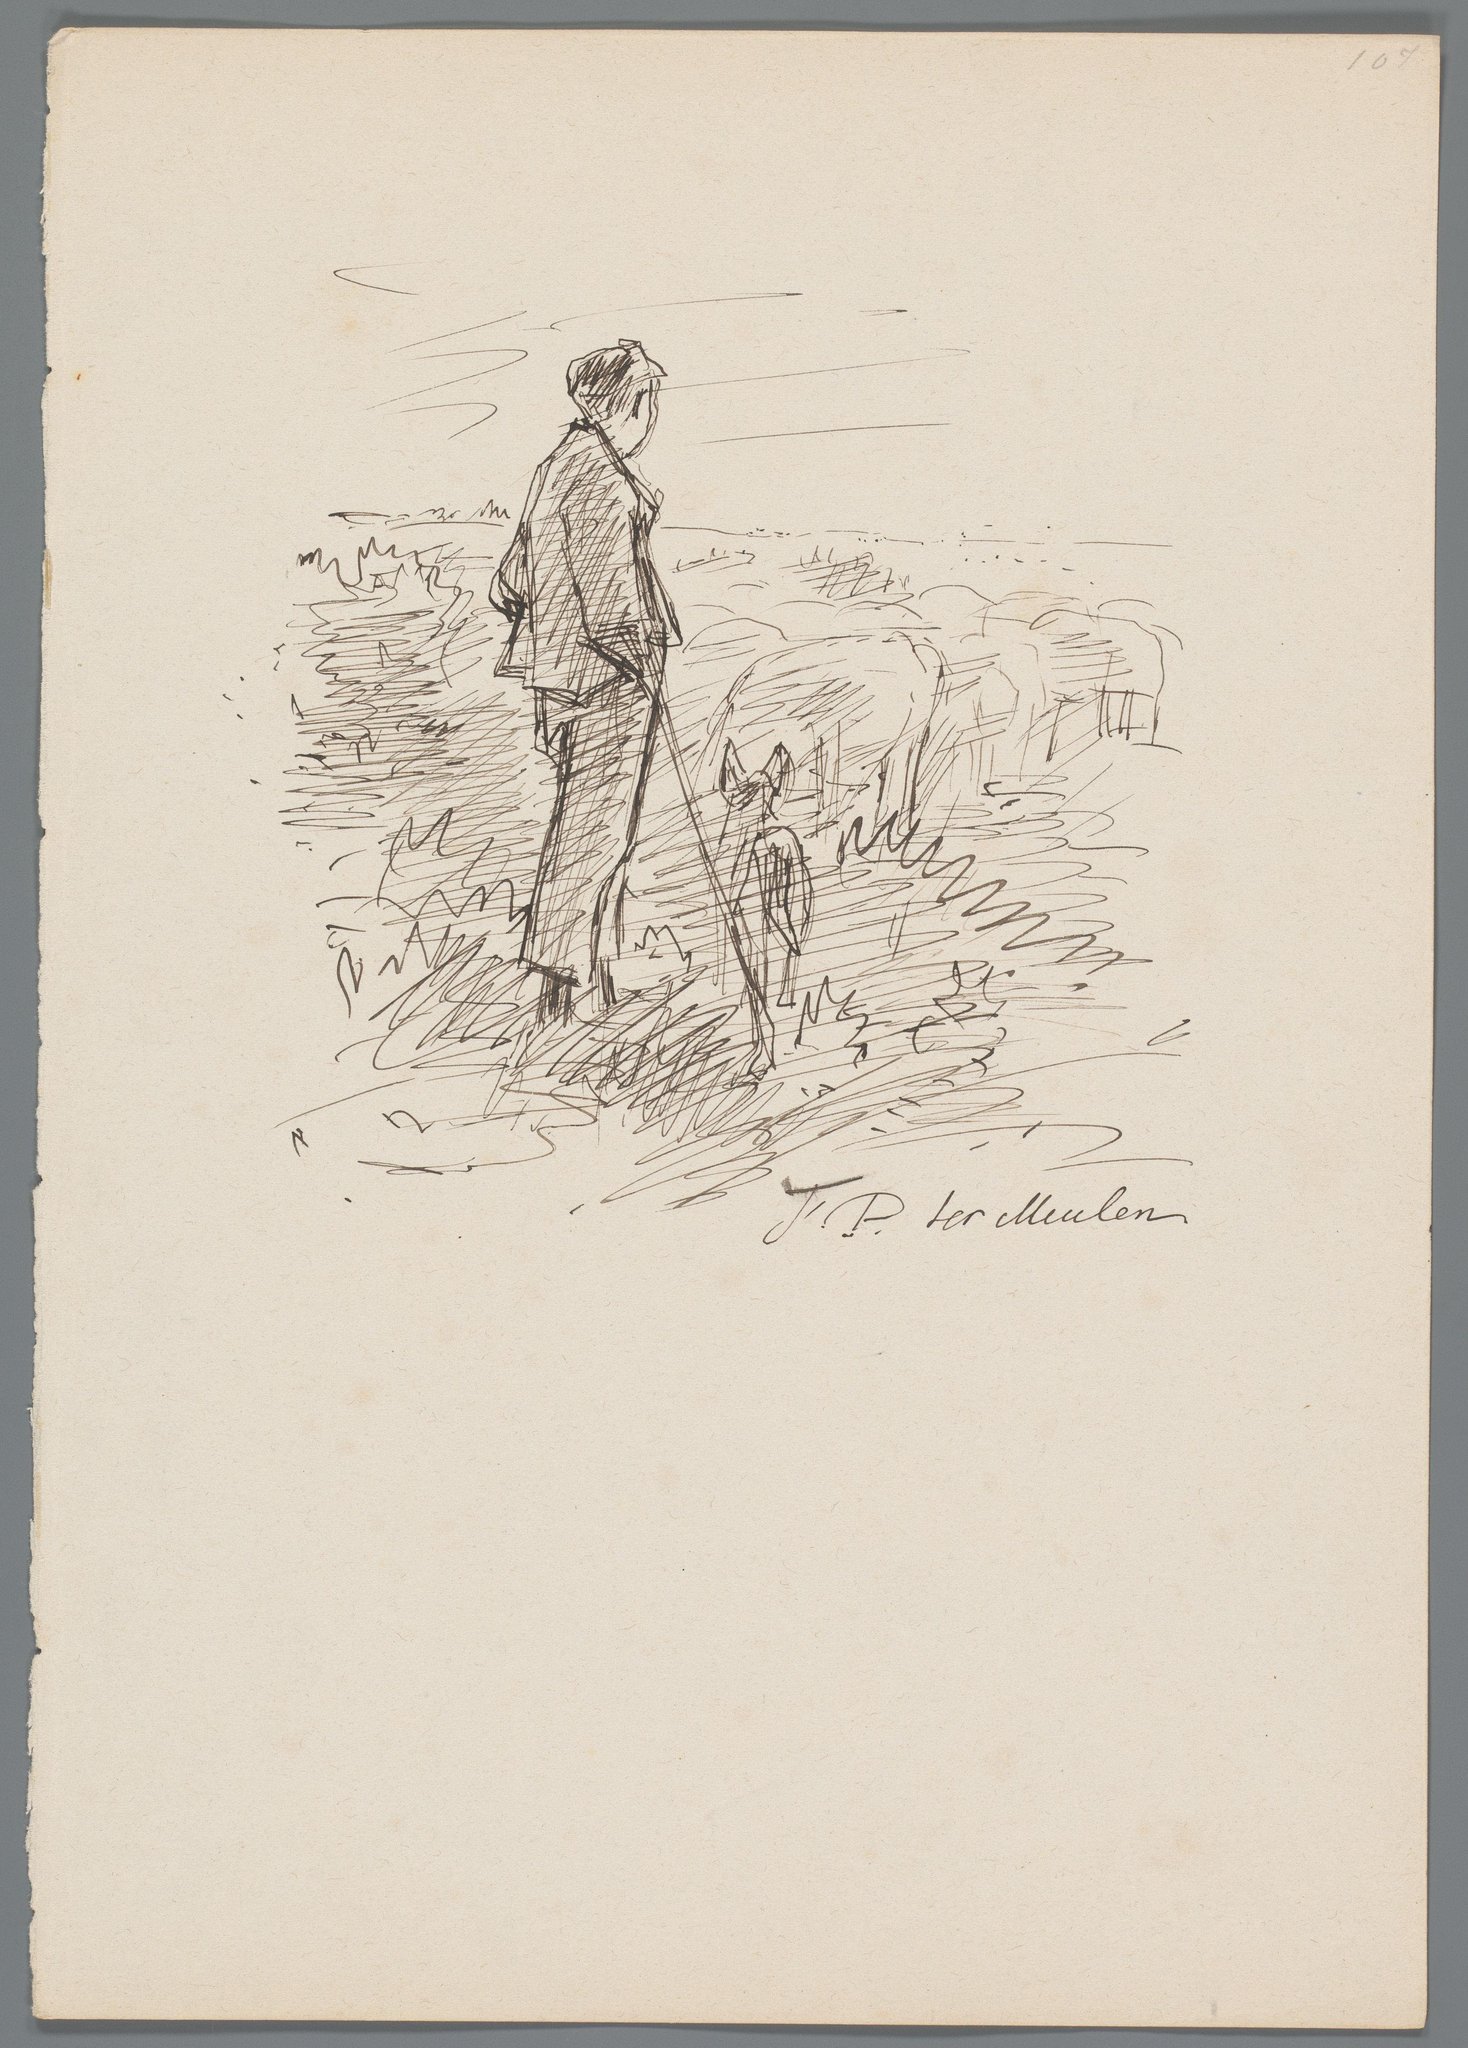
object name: drawing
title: Herder met hond en schapen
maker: françois pieter ter meulen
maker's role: painter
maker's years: 1843-1927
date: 1894-1919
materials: ink, paper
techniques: pen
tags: herding, herdsman, herdswoman, shepherd, shepherdess, cowherd, etc., herd, flock